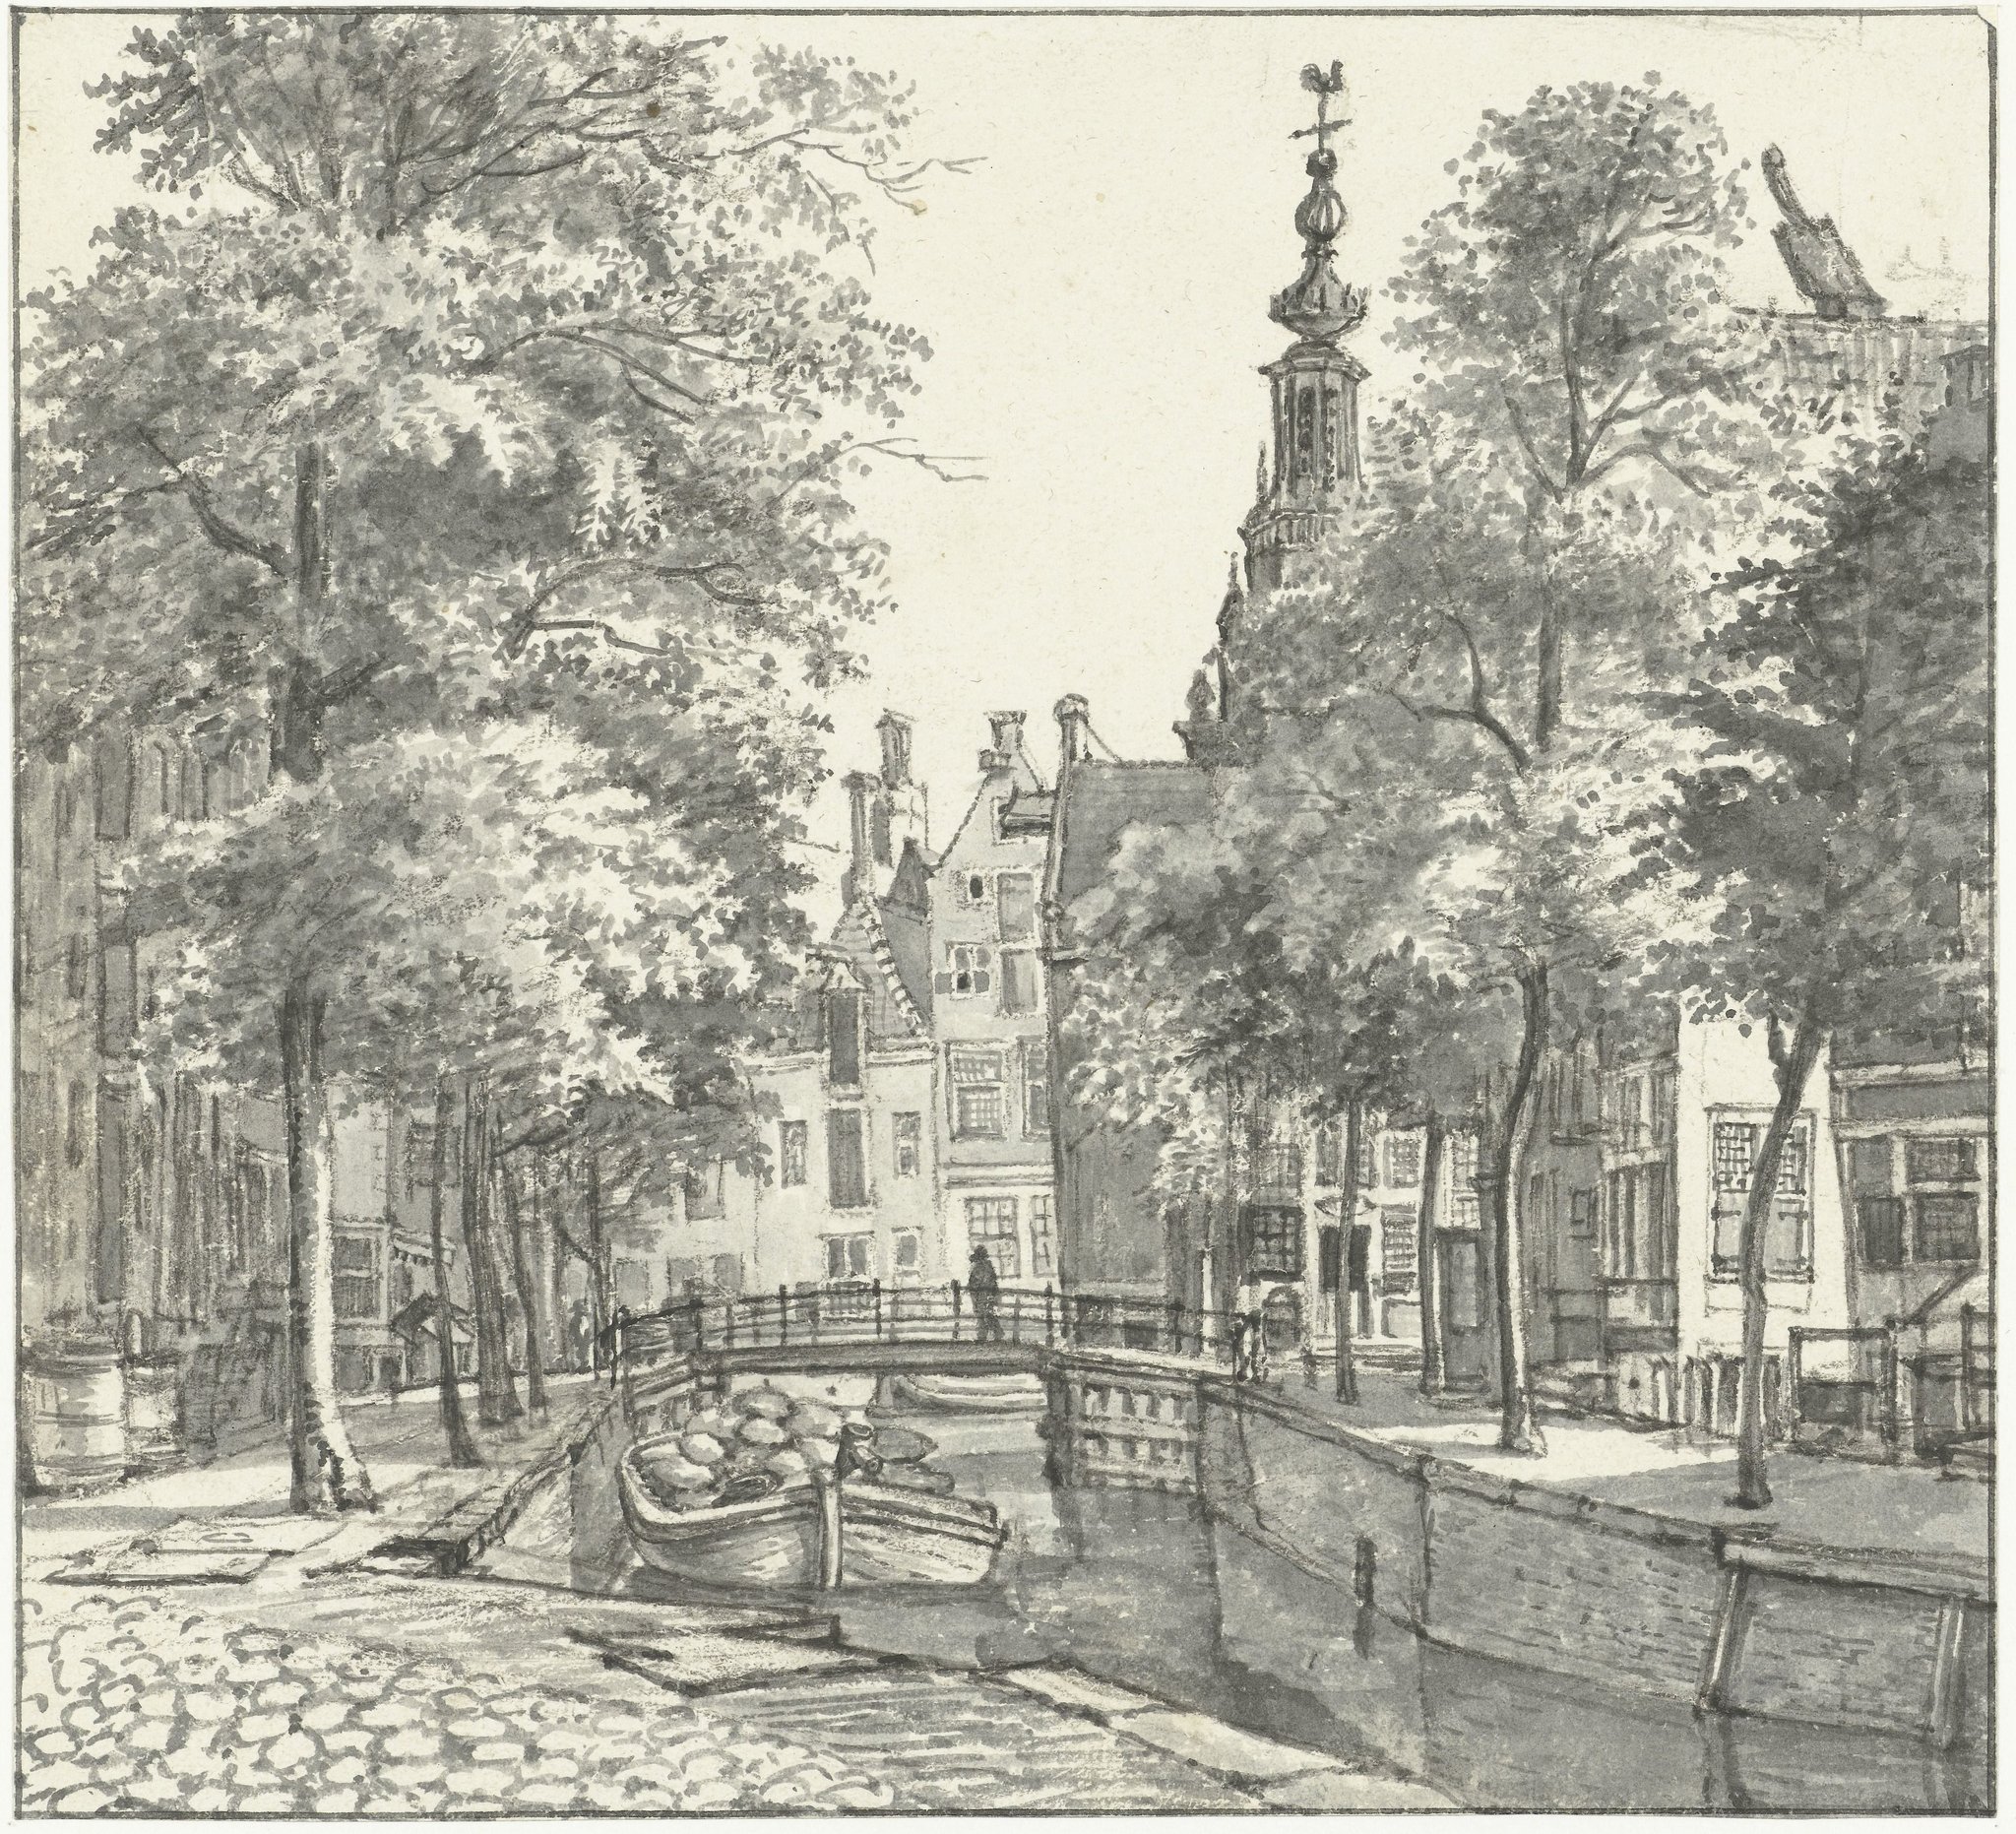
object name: drawing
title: Gezicht op de Krom Boomsloot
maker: gerrit lamberts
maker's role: bookseller, draughtsman, print maker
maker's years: 1776-1850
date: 1817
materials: chalk, ink, paper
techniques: brush, pen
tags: canals, waters (in city)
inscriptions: inscription: ‘Gezicht op het Dwarsboom-sloot, ziende naar de Zuyderkerks Tooren’